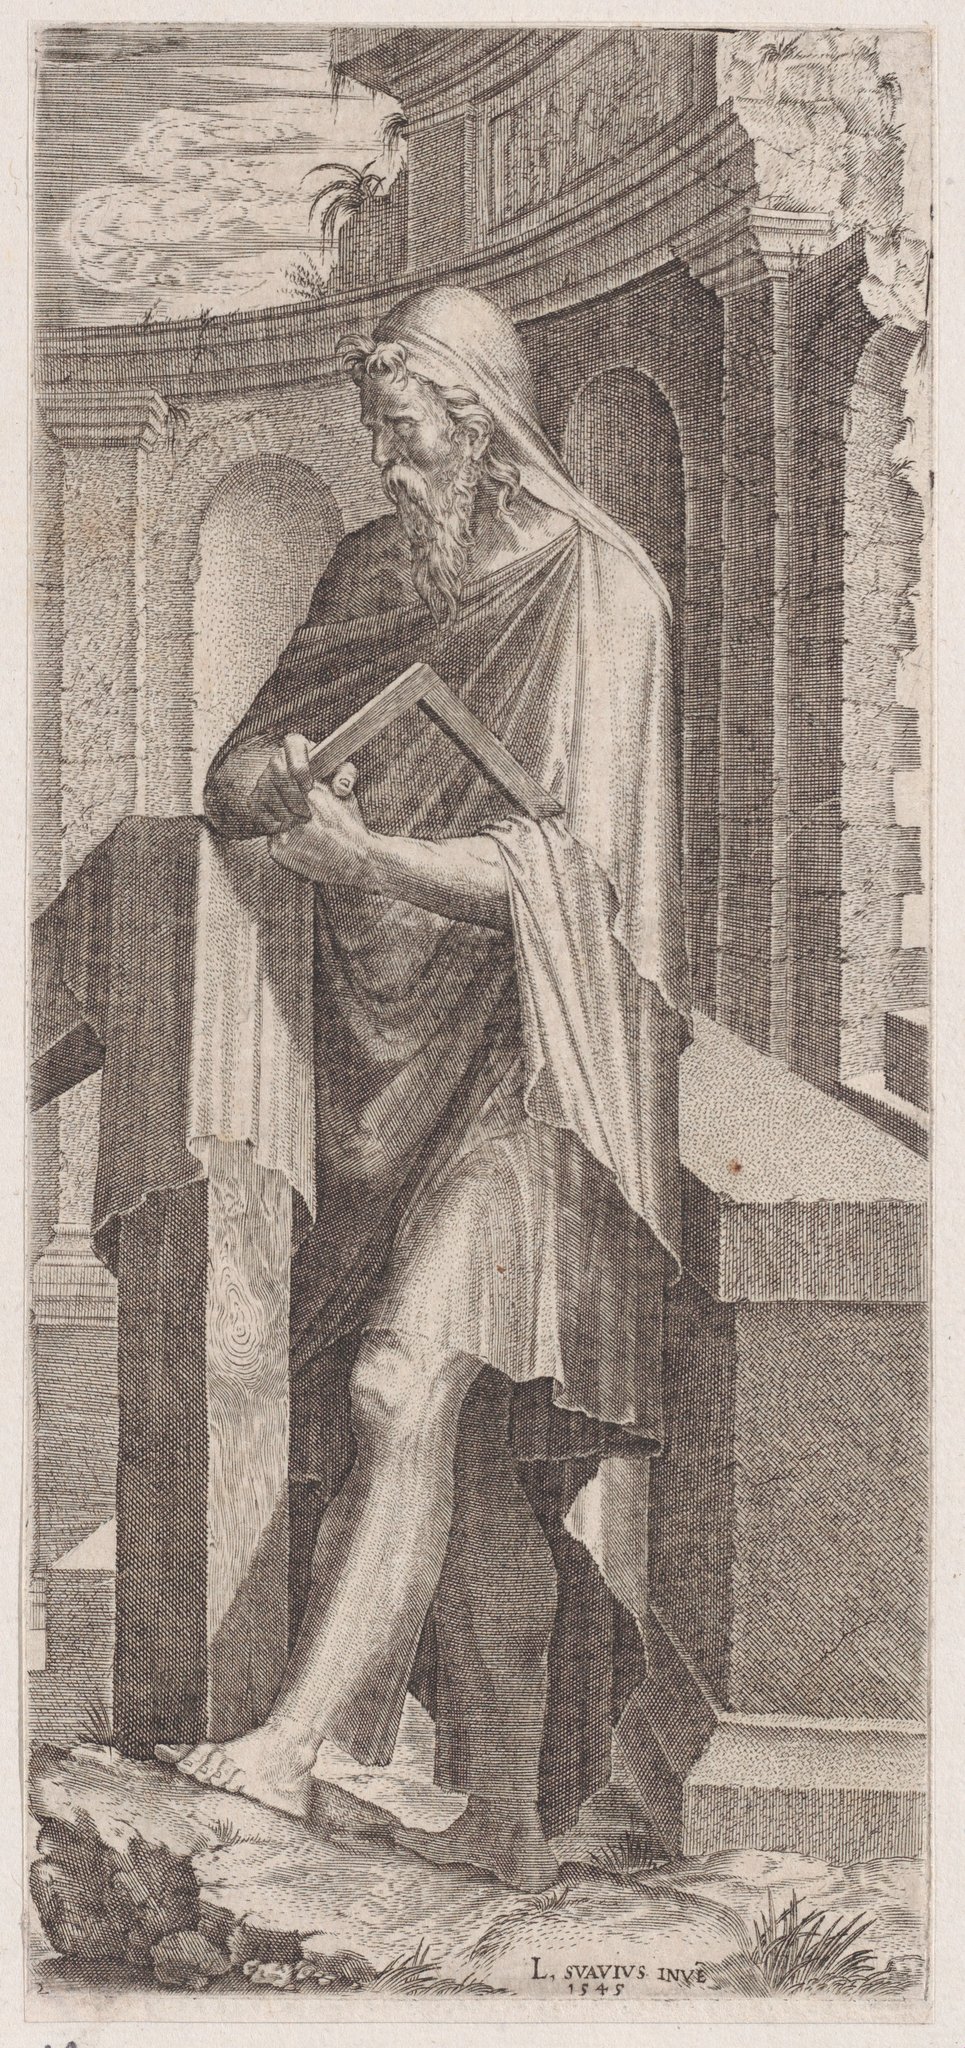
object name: print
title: St. Judas Thaddaeus, from "Christ, the Twelve Apostles and St. Paul"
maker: lambert suavius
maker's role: artist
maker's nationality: netherlandish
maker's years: 1510-1576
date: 1525-1576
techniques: engraving